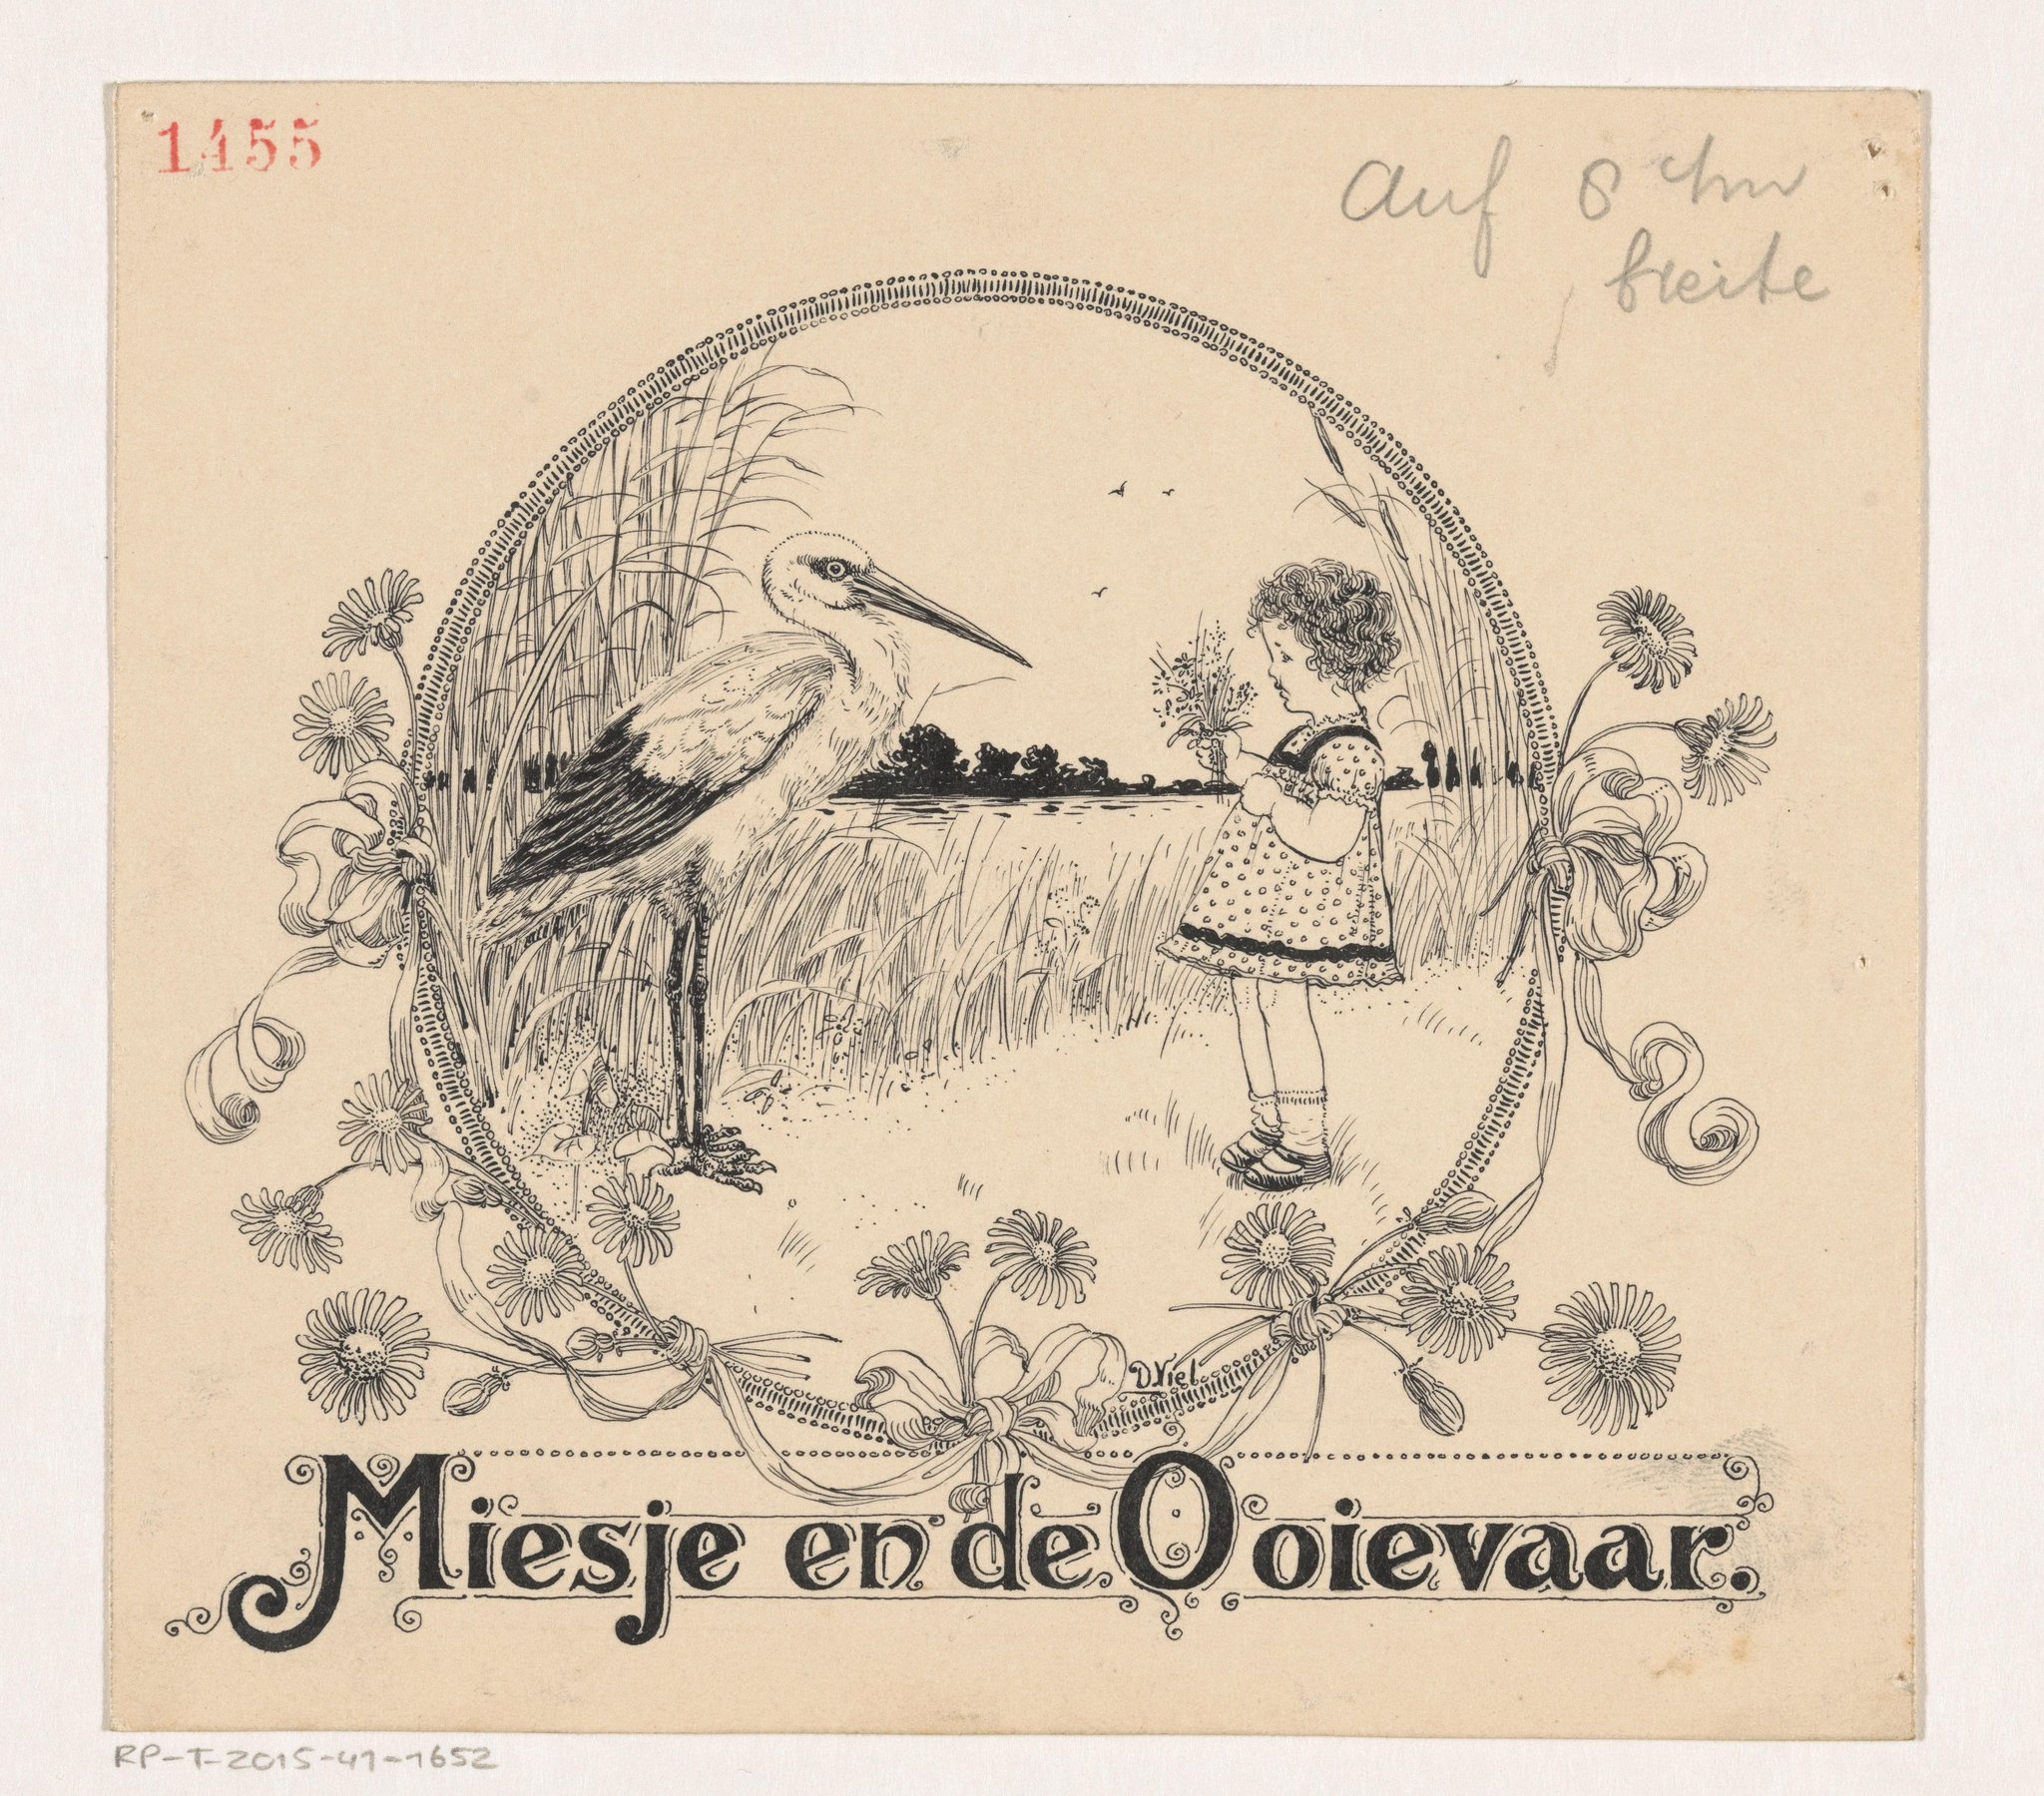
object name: drawing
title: Miesje brengt een bos bloemen naar een ooievaar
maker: d. viel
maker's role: draughtsman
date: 1915-1935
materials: ink, paper, pencil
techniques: pen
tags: cut flowers; nosegay, bunch of flowers, shore-birds and wading-birds: stork, landscapes with waters, waterscapes, seascapes (in the temperate zone)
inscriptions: :, collector's mark: Lugt 2228, signature: ‘D.Viel.’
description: Voorstelling in een cirkel versierd met bloemen.